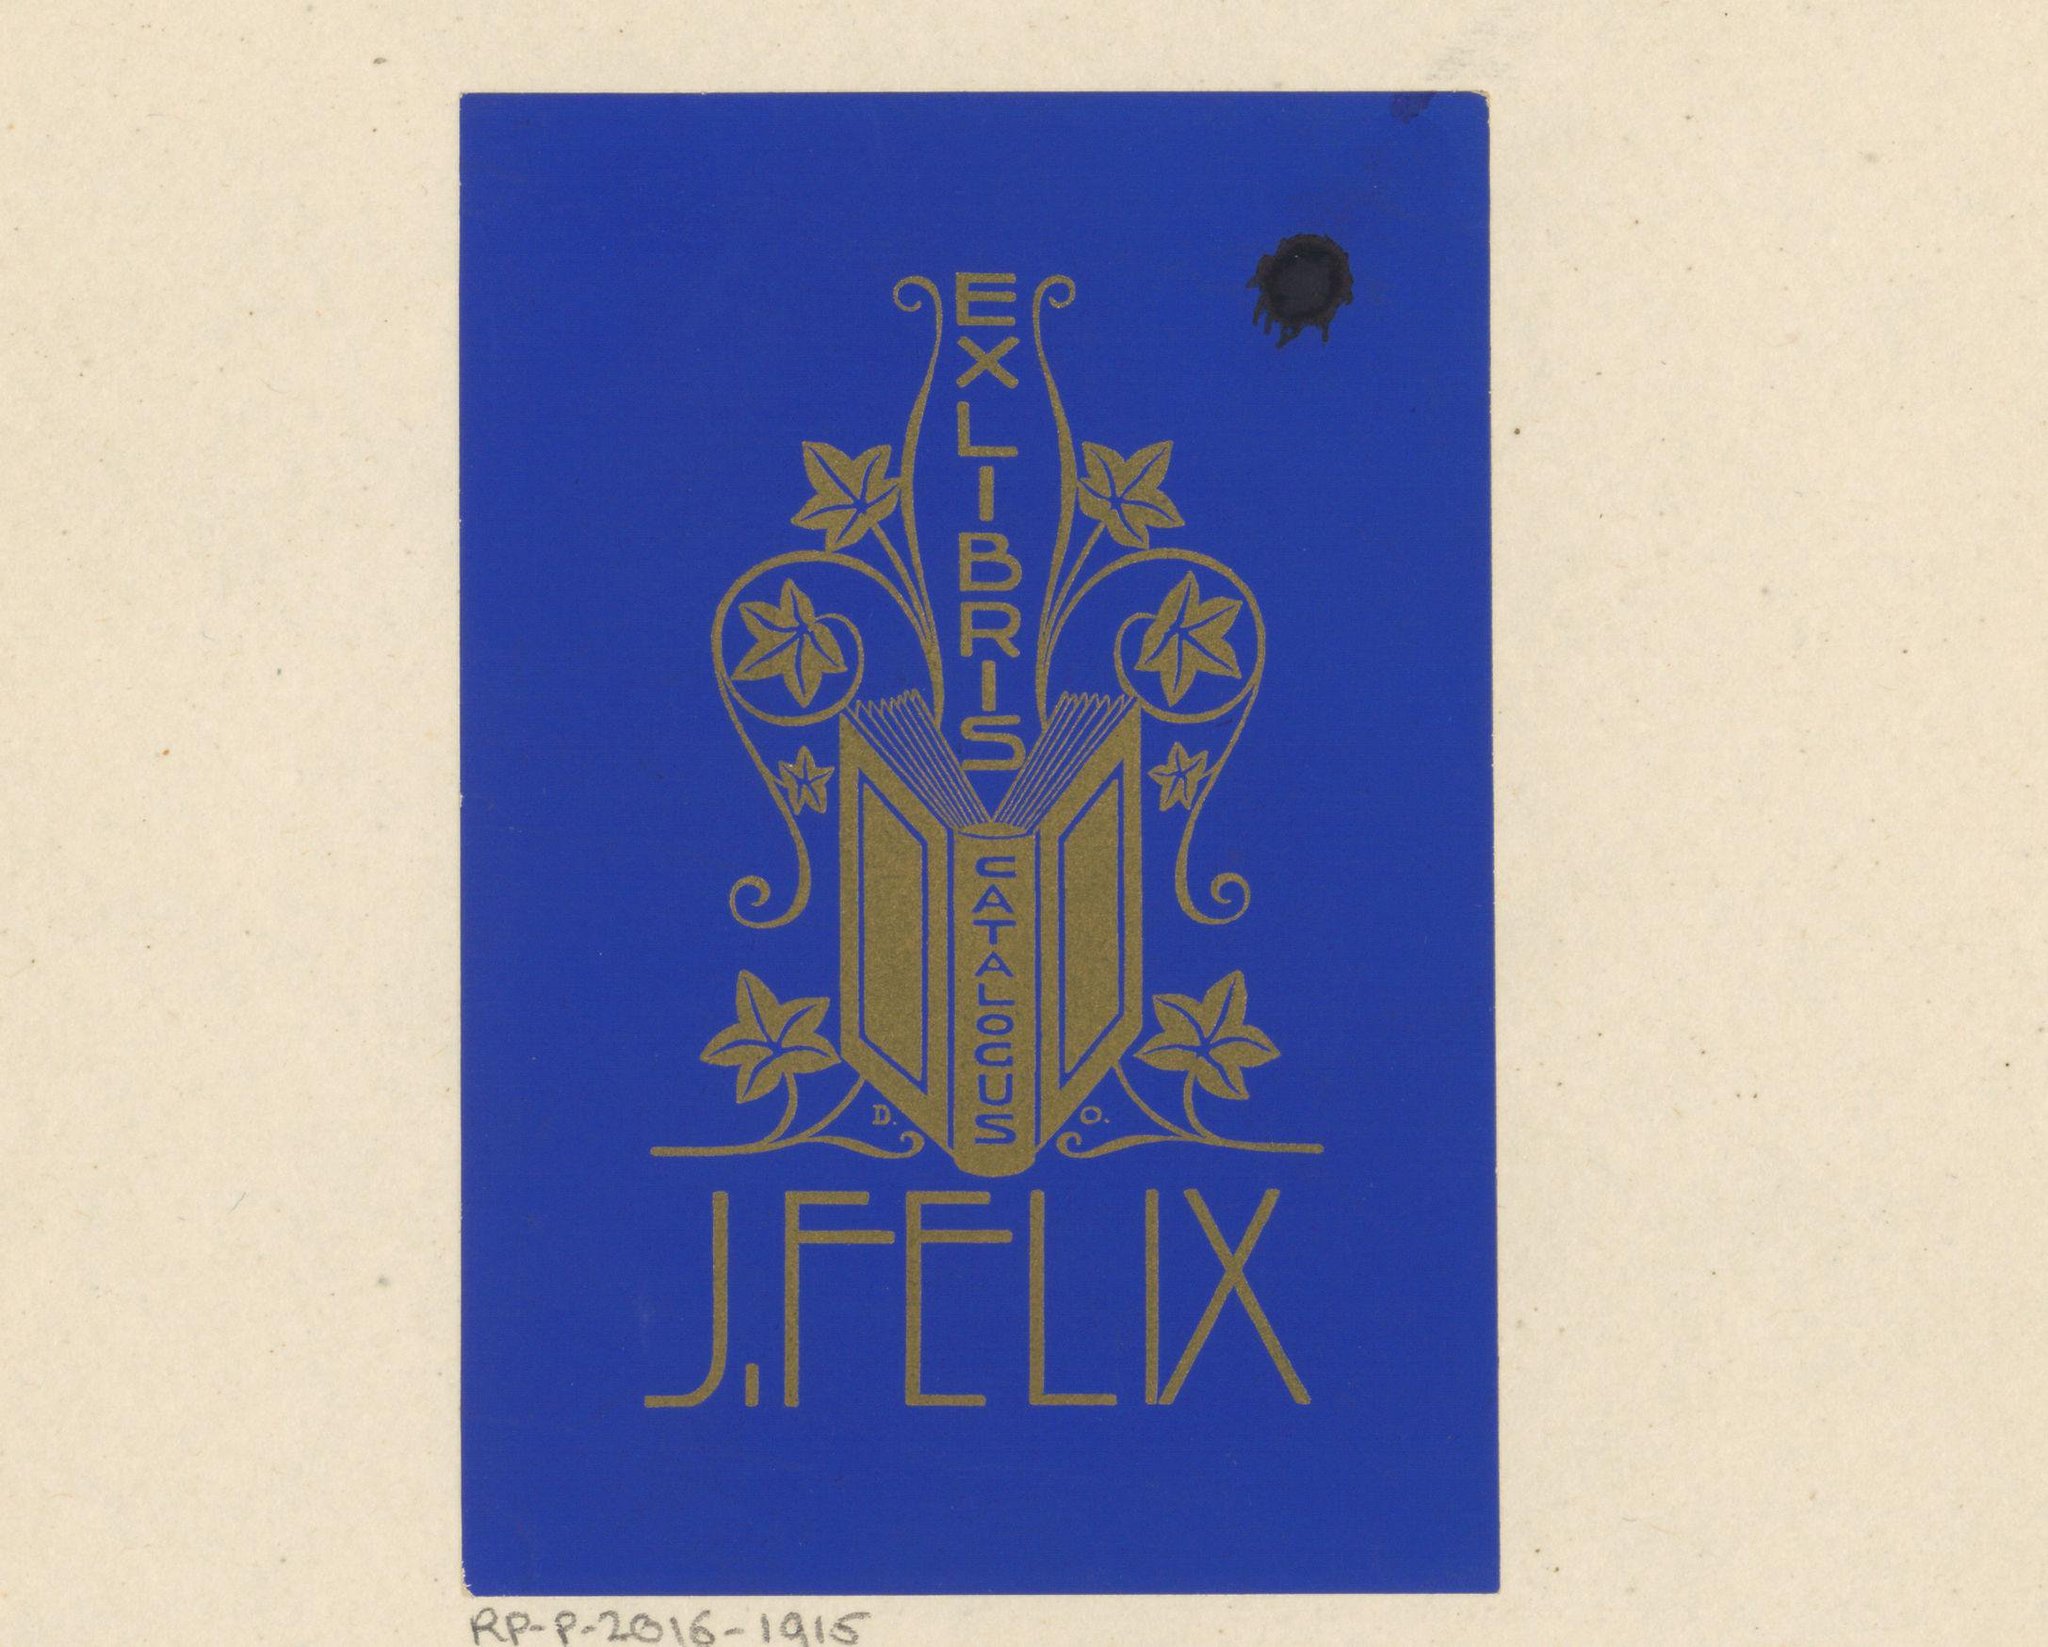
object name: bookplate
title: Ex libris van Jan Felix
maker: h.f.d. oxenaar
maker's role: print maker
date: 1935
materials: paper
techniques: printing block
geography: netherlands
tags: print maker, politician, book, plants and herbs: ivy